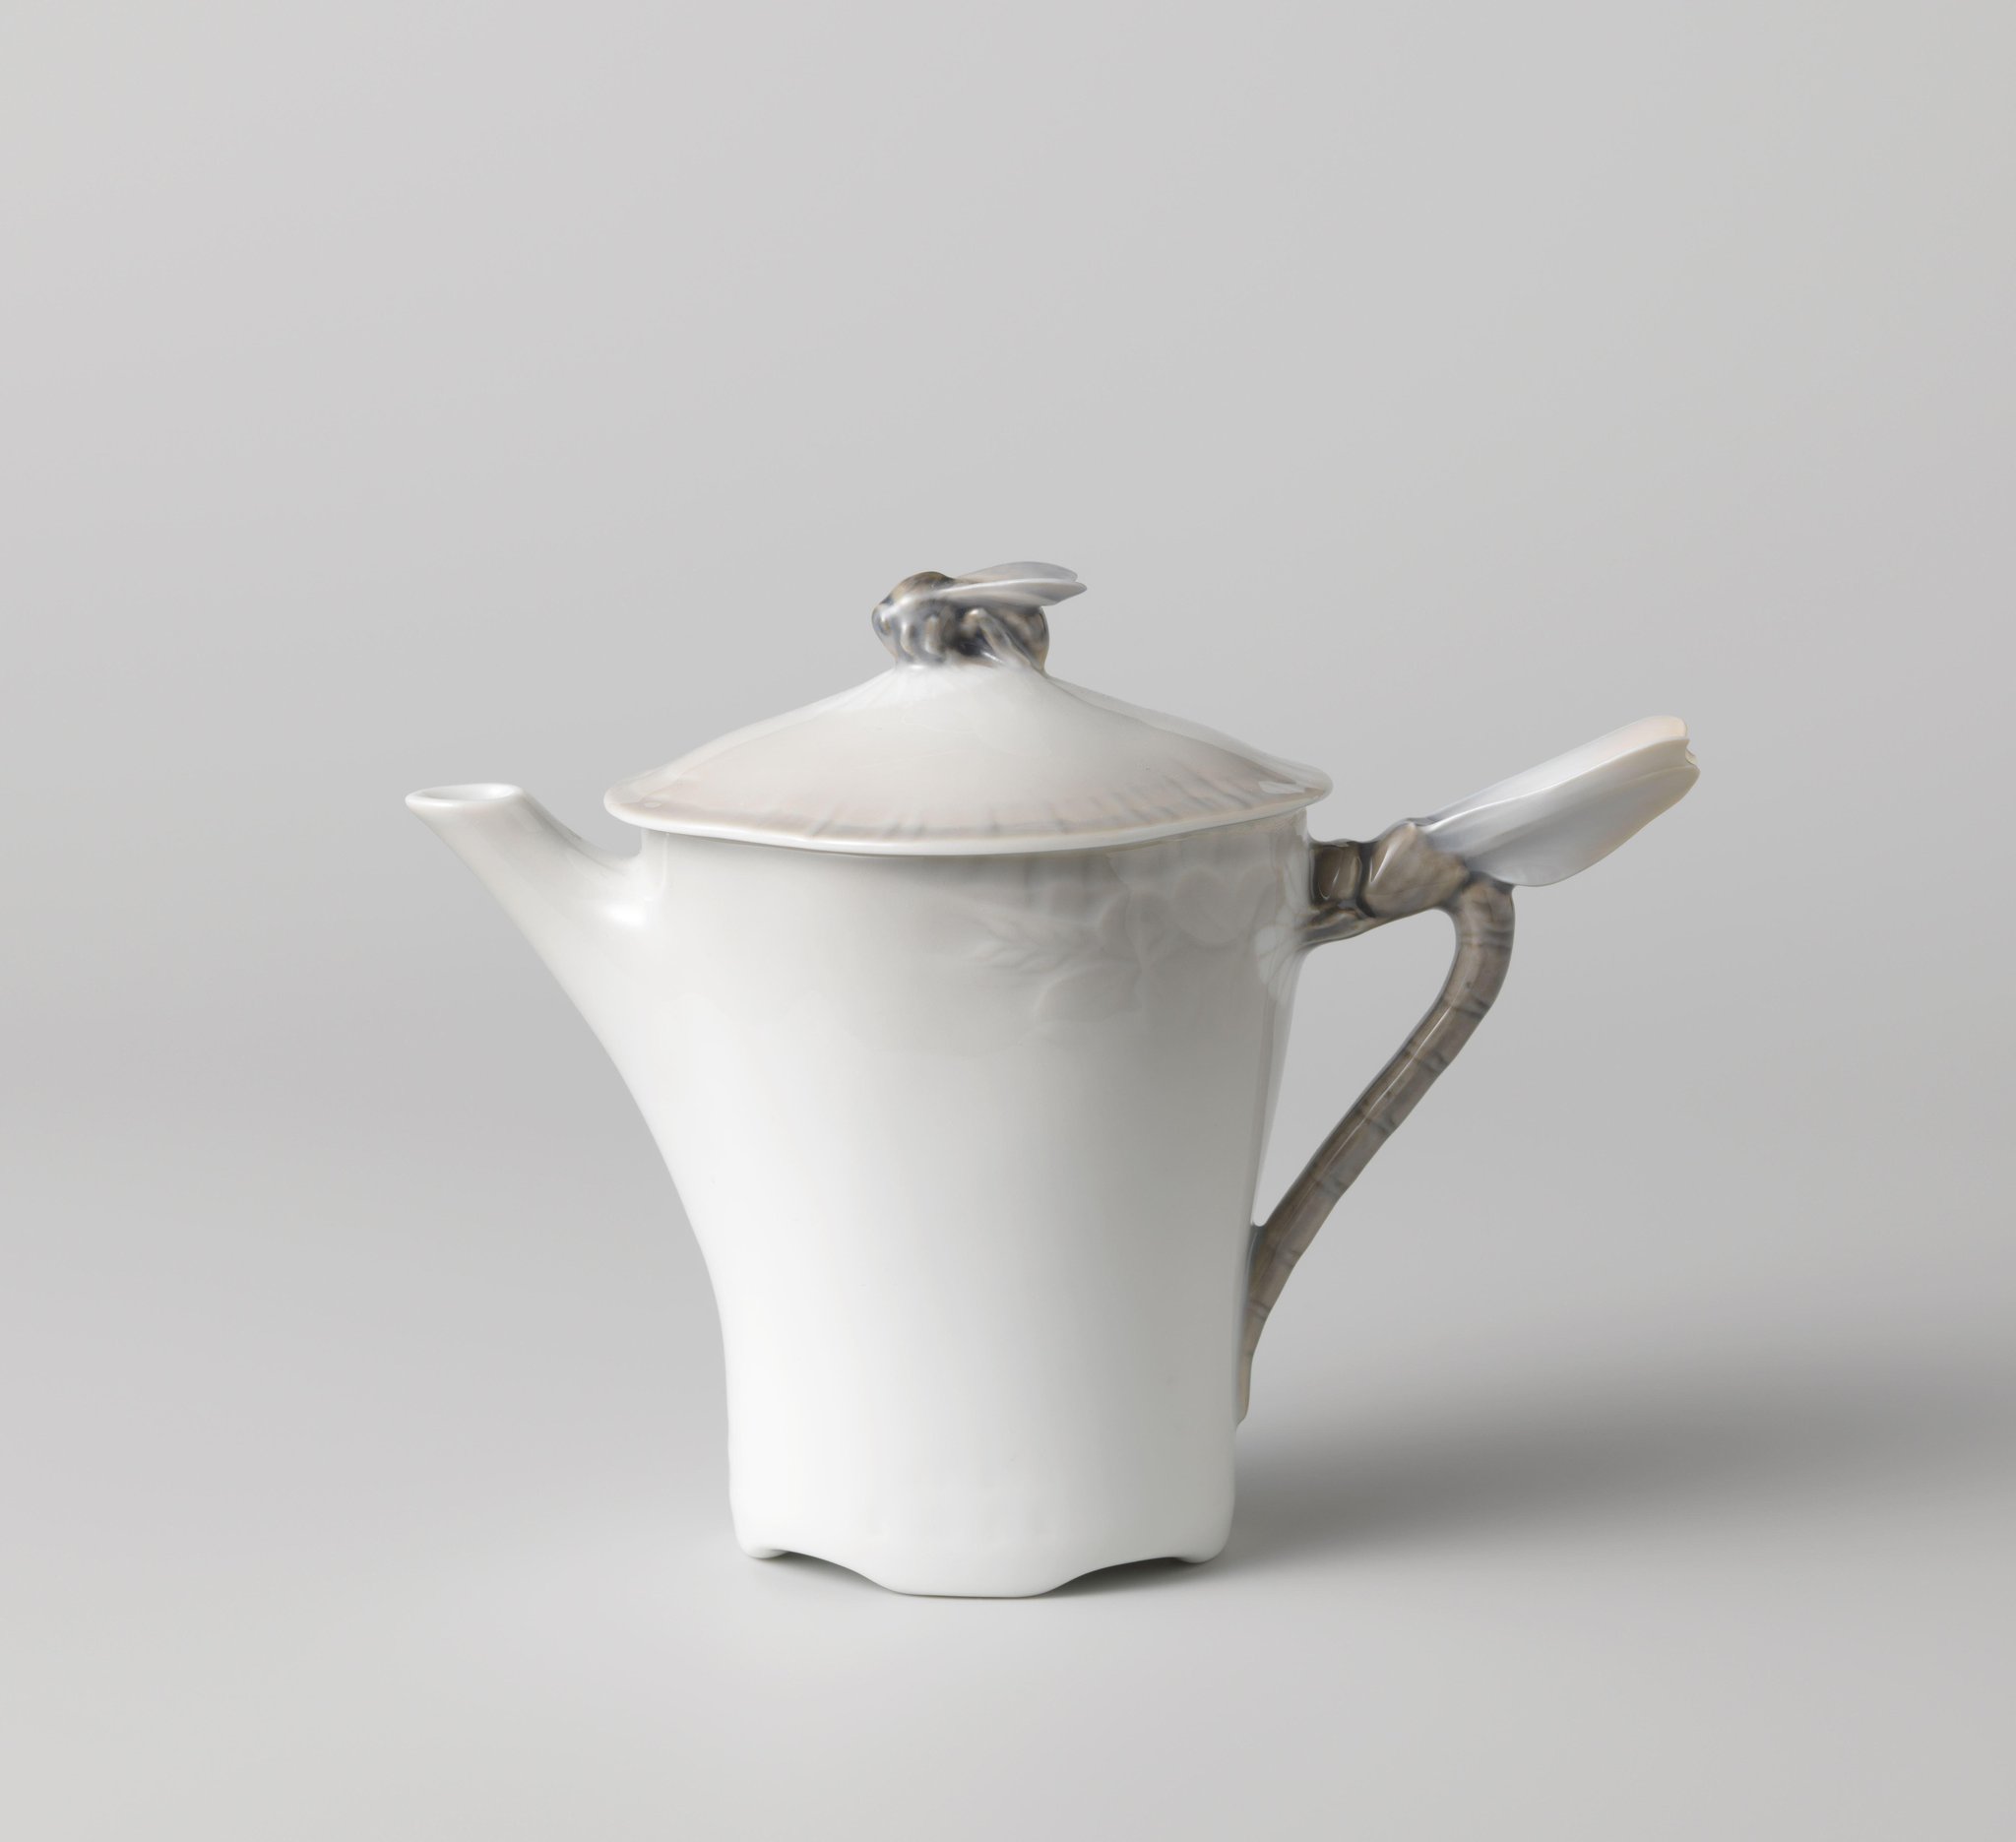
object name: coffee pot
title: Koffiepot, behorende bij een servies met libellen, vlinders en andere insekten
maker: arnold emil krog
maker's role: ceramicist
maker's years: 1856-1937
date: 1894-1899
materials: porcelain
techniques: painted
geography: copenhagen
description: Koffiepot, behorende bij een servies van porselein. De koffiepot heeft een libel als oor. Langs de randen versierd met bladeren en margrieten, welke laatste in het paars-grijze fond waarmee de stukken zijn bedekt, zijn uitgespaard. Gemerkt. Koninklijke Porseleinfabriek Kopenhagen.